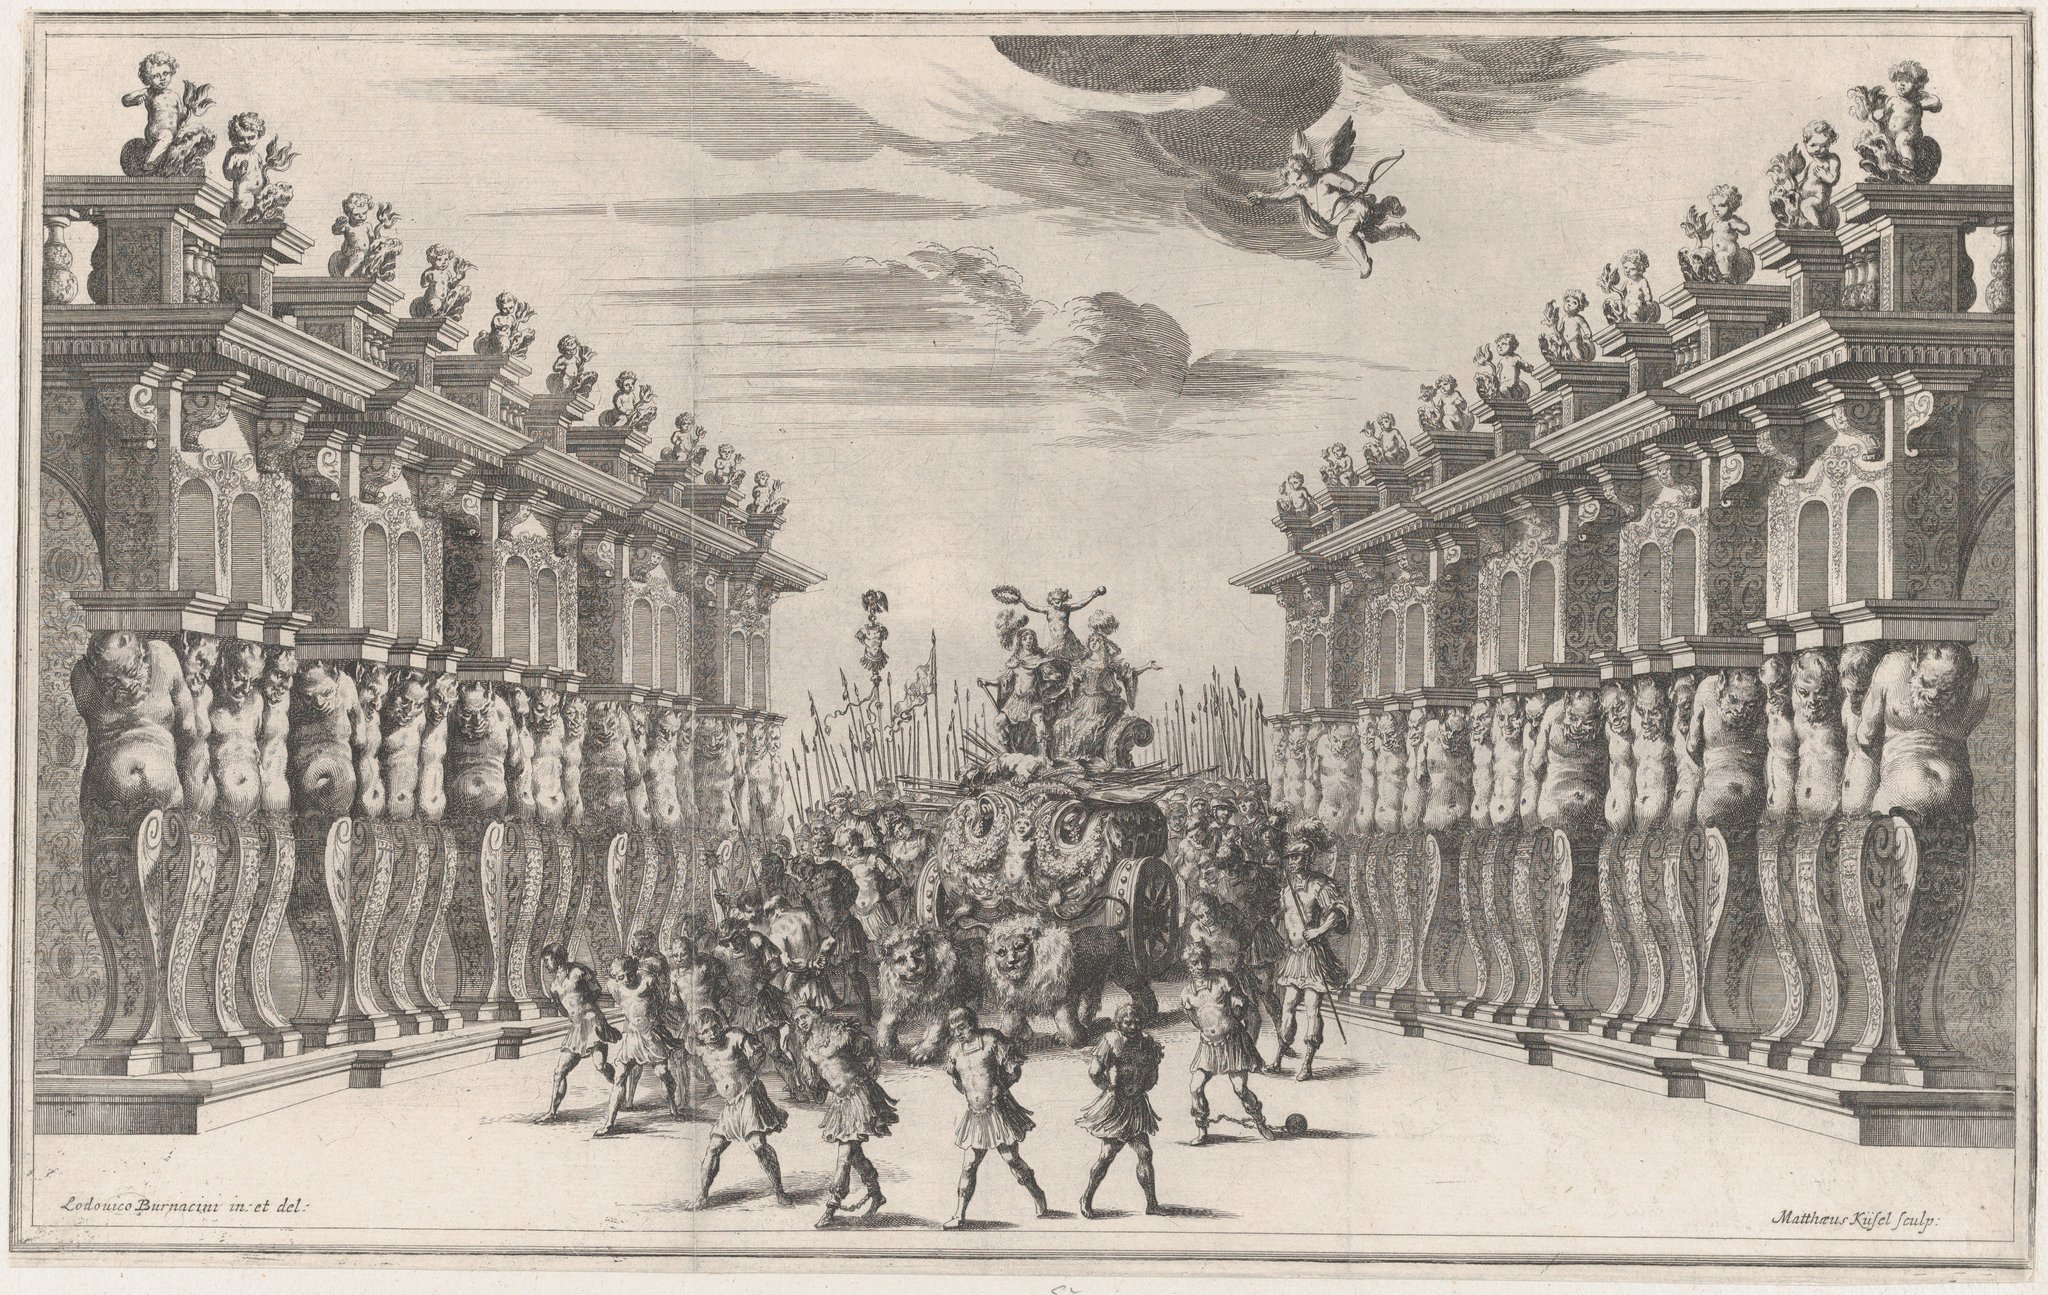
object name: print, fete, ornament architecture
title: Atrium of the Palace of Venus; set design from 'Il Pomo D'Oro'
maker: mathäus küsel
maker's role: artist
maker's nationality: german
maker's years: 1621-1682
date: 1668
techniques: etching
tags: opera,palaces,men,lions,chariots